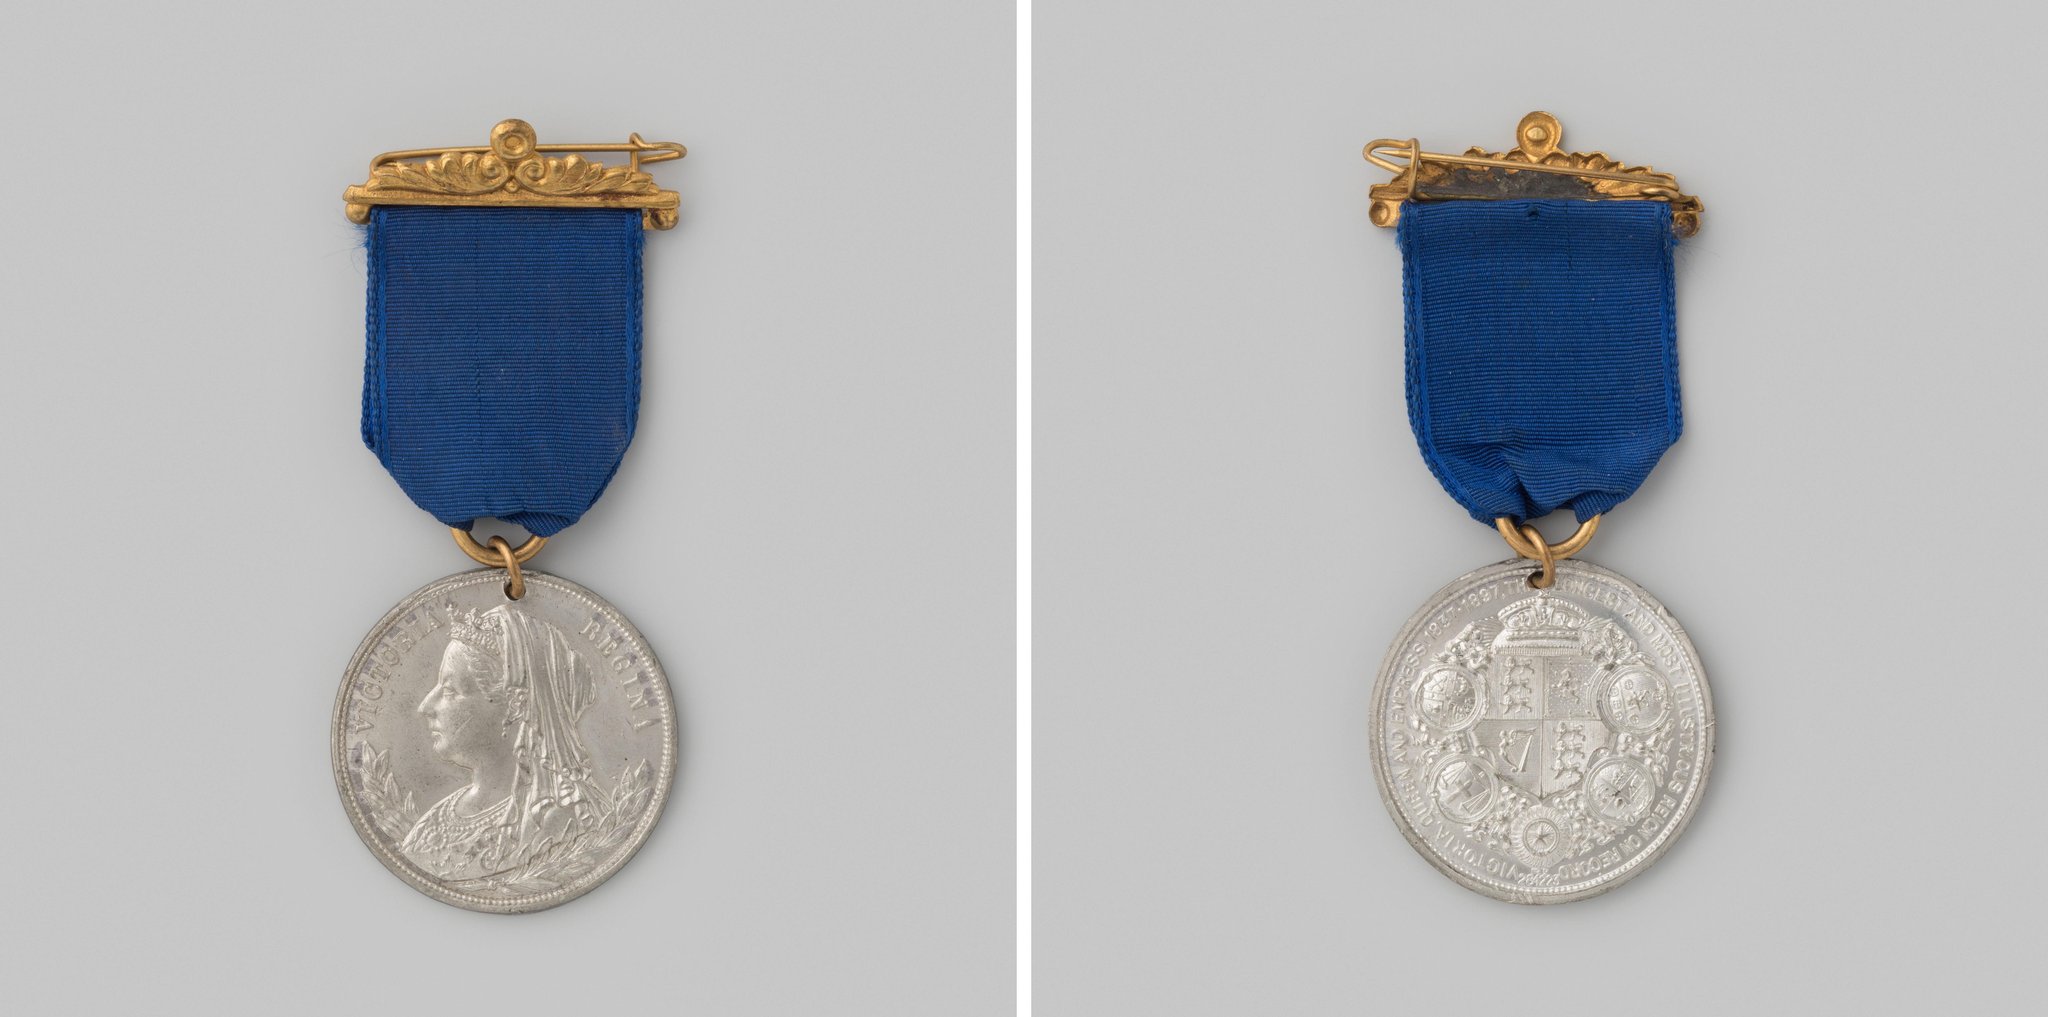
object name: history medal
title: Zestigjarig regeringsjubileum Koningin Victoria van Engeland 1897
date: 1897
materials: brass, textile, tin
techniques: striking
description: Tinnen penning met gat en draagring aan blauw lint met messing sierspeld, op de voorzijde het borstbeeld van Victoria naar links op lauwertakken, met omschrift, op de keerzijde het gekroonde Engelse wapenschild waarom vijf met linten verbonden medaillons, met omschrift.